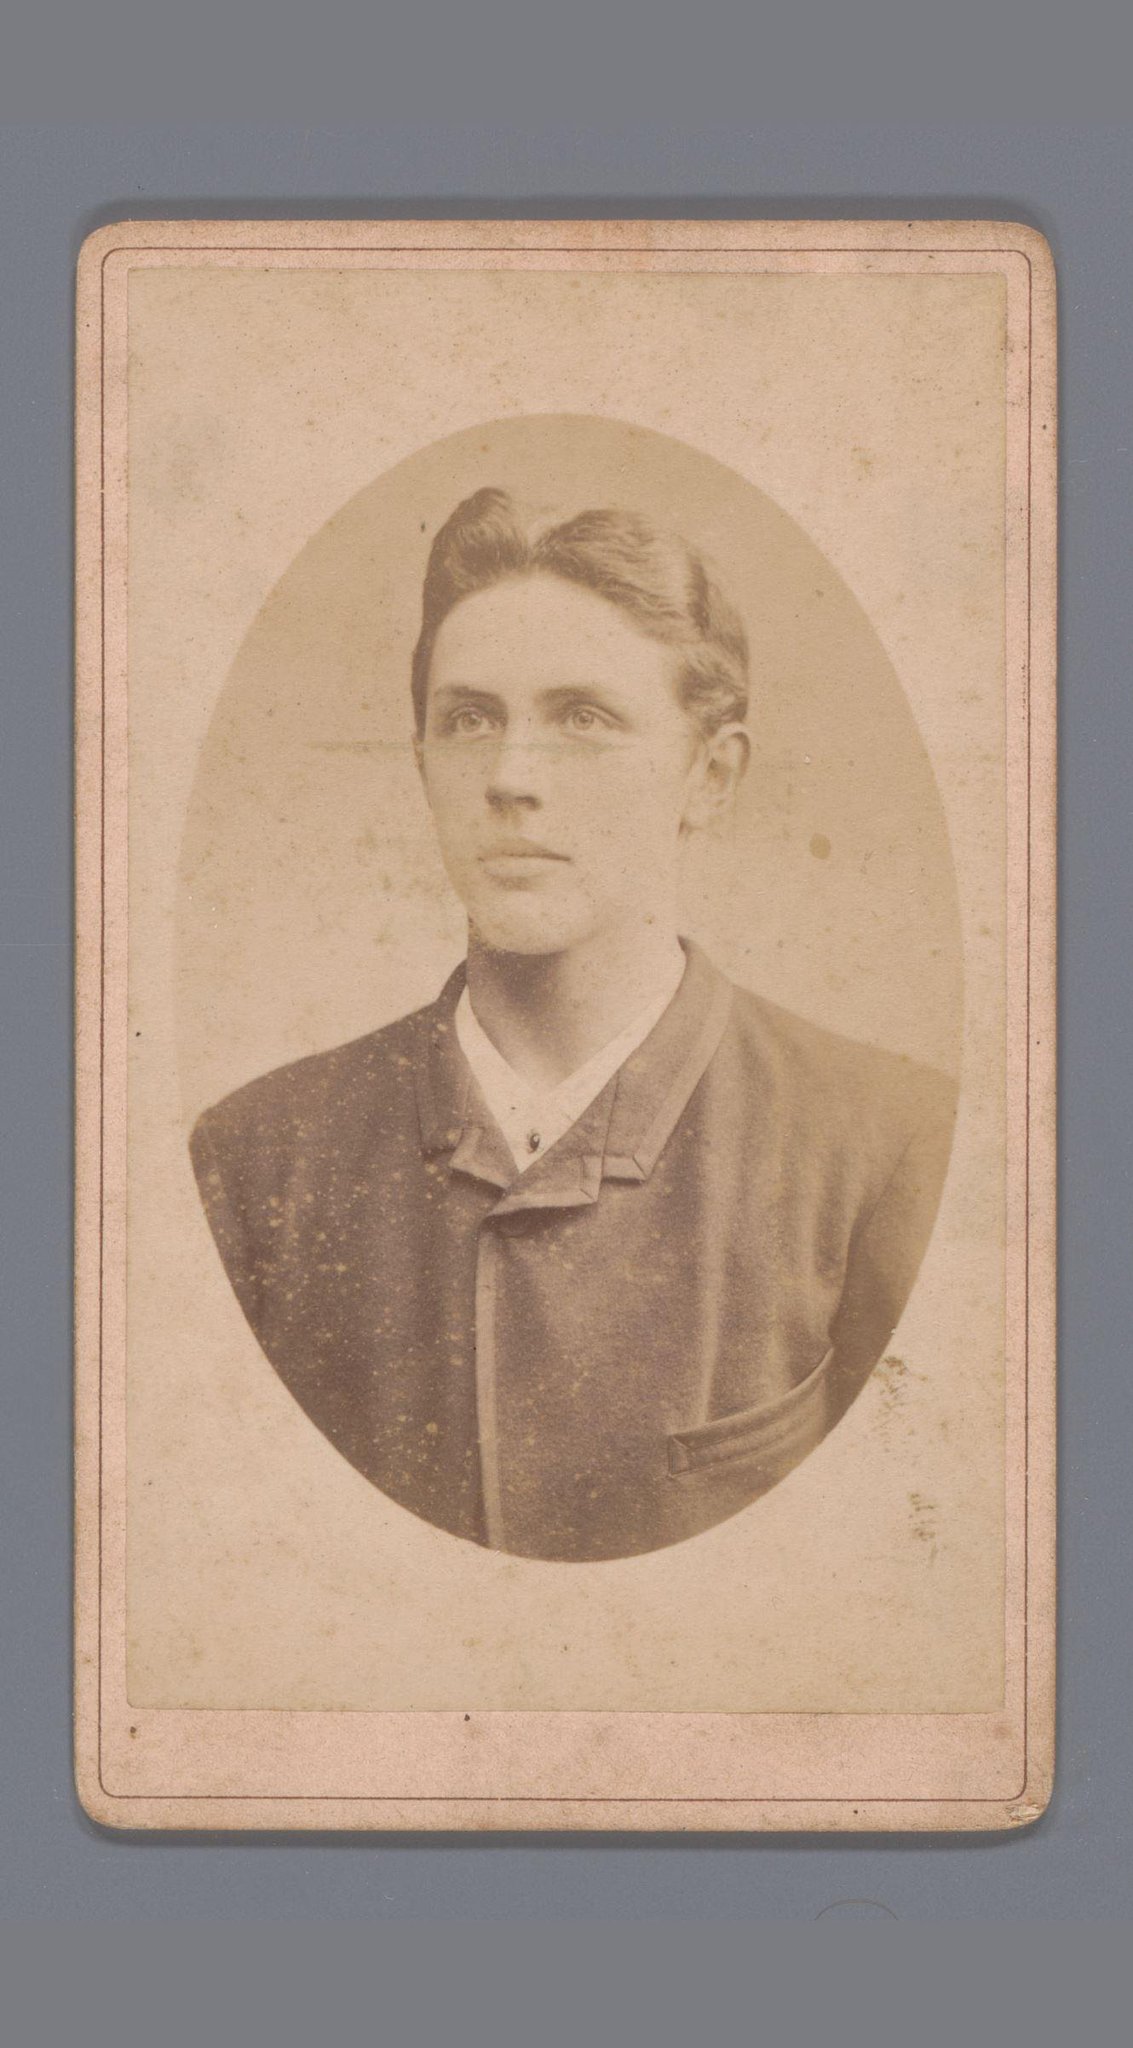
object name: photograph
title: Portret van een onbekende man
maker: friedrich julius von kolkow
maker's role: fotograaf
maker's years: 1839-1914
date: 1884-1896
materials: cardboard, paper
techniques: albumen print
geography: groningen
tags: adult man, historical persons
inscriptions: inscription: ‘GOUDEN MEDALJE VOOR KUNST EN WETENSCHAP v Z. M. de KONING v WÜRTTEMBERG/ aan het lint der Frederiksorde/ PHILADELPHIA 1876. WIEN 1873./ FR. JUL. VON KOLKOW/ KONINKLIJK NEDERLANDSCH HOF-PHOTOGRAPH/ Silberne Voigtländer Medaille Kunst u Wissenschaft Oldenburg/ en tien zilveren Medaljes op andere Tentoonstellingen./ GRONINGEN/ Groote Markt bij de/ Martinitoorn./ Specialiteit in Vergrootingen.’